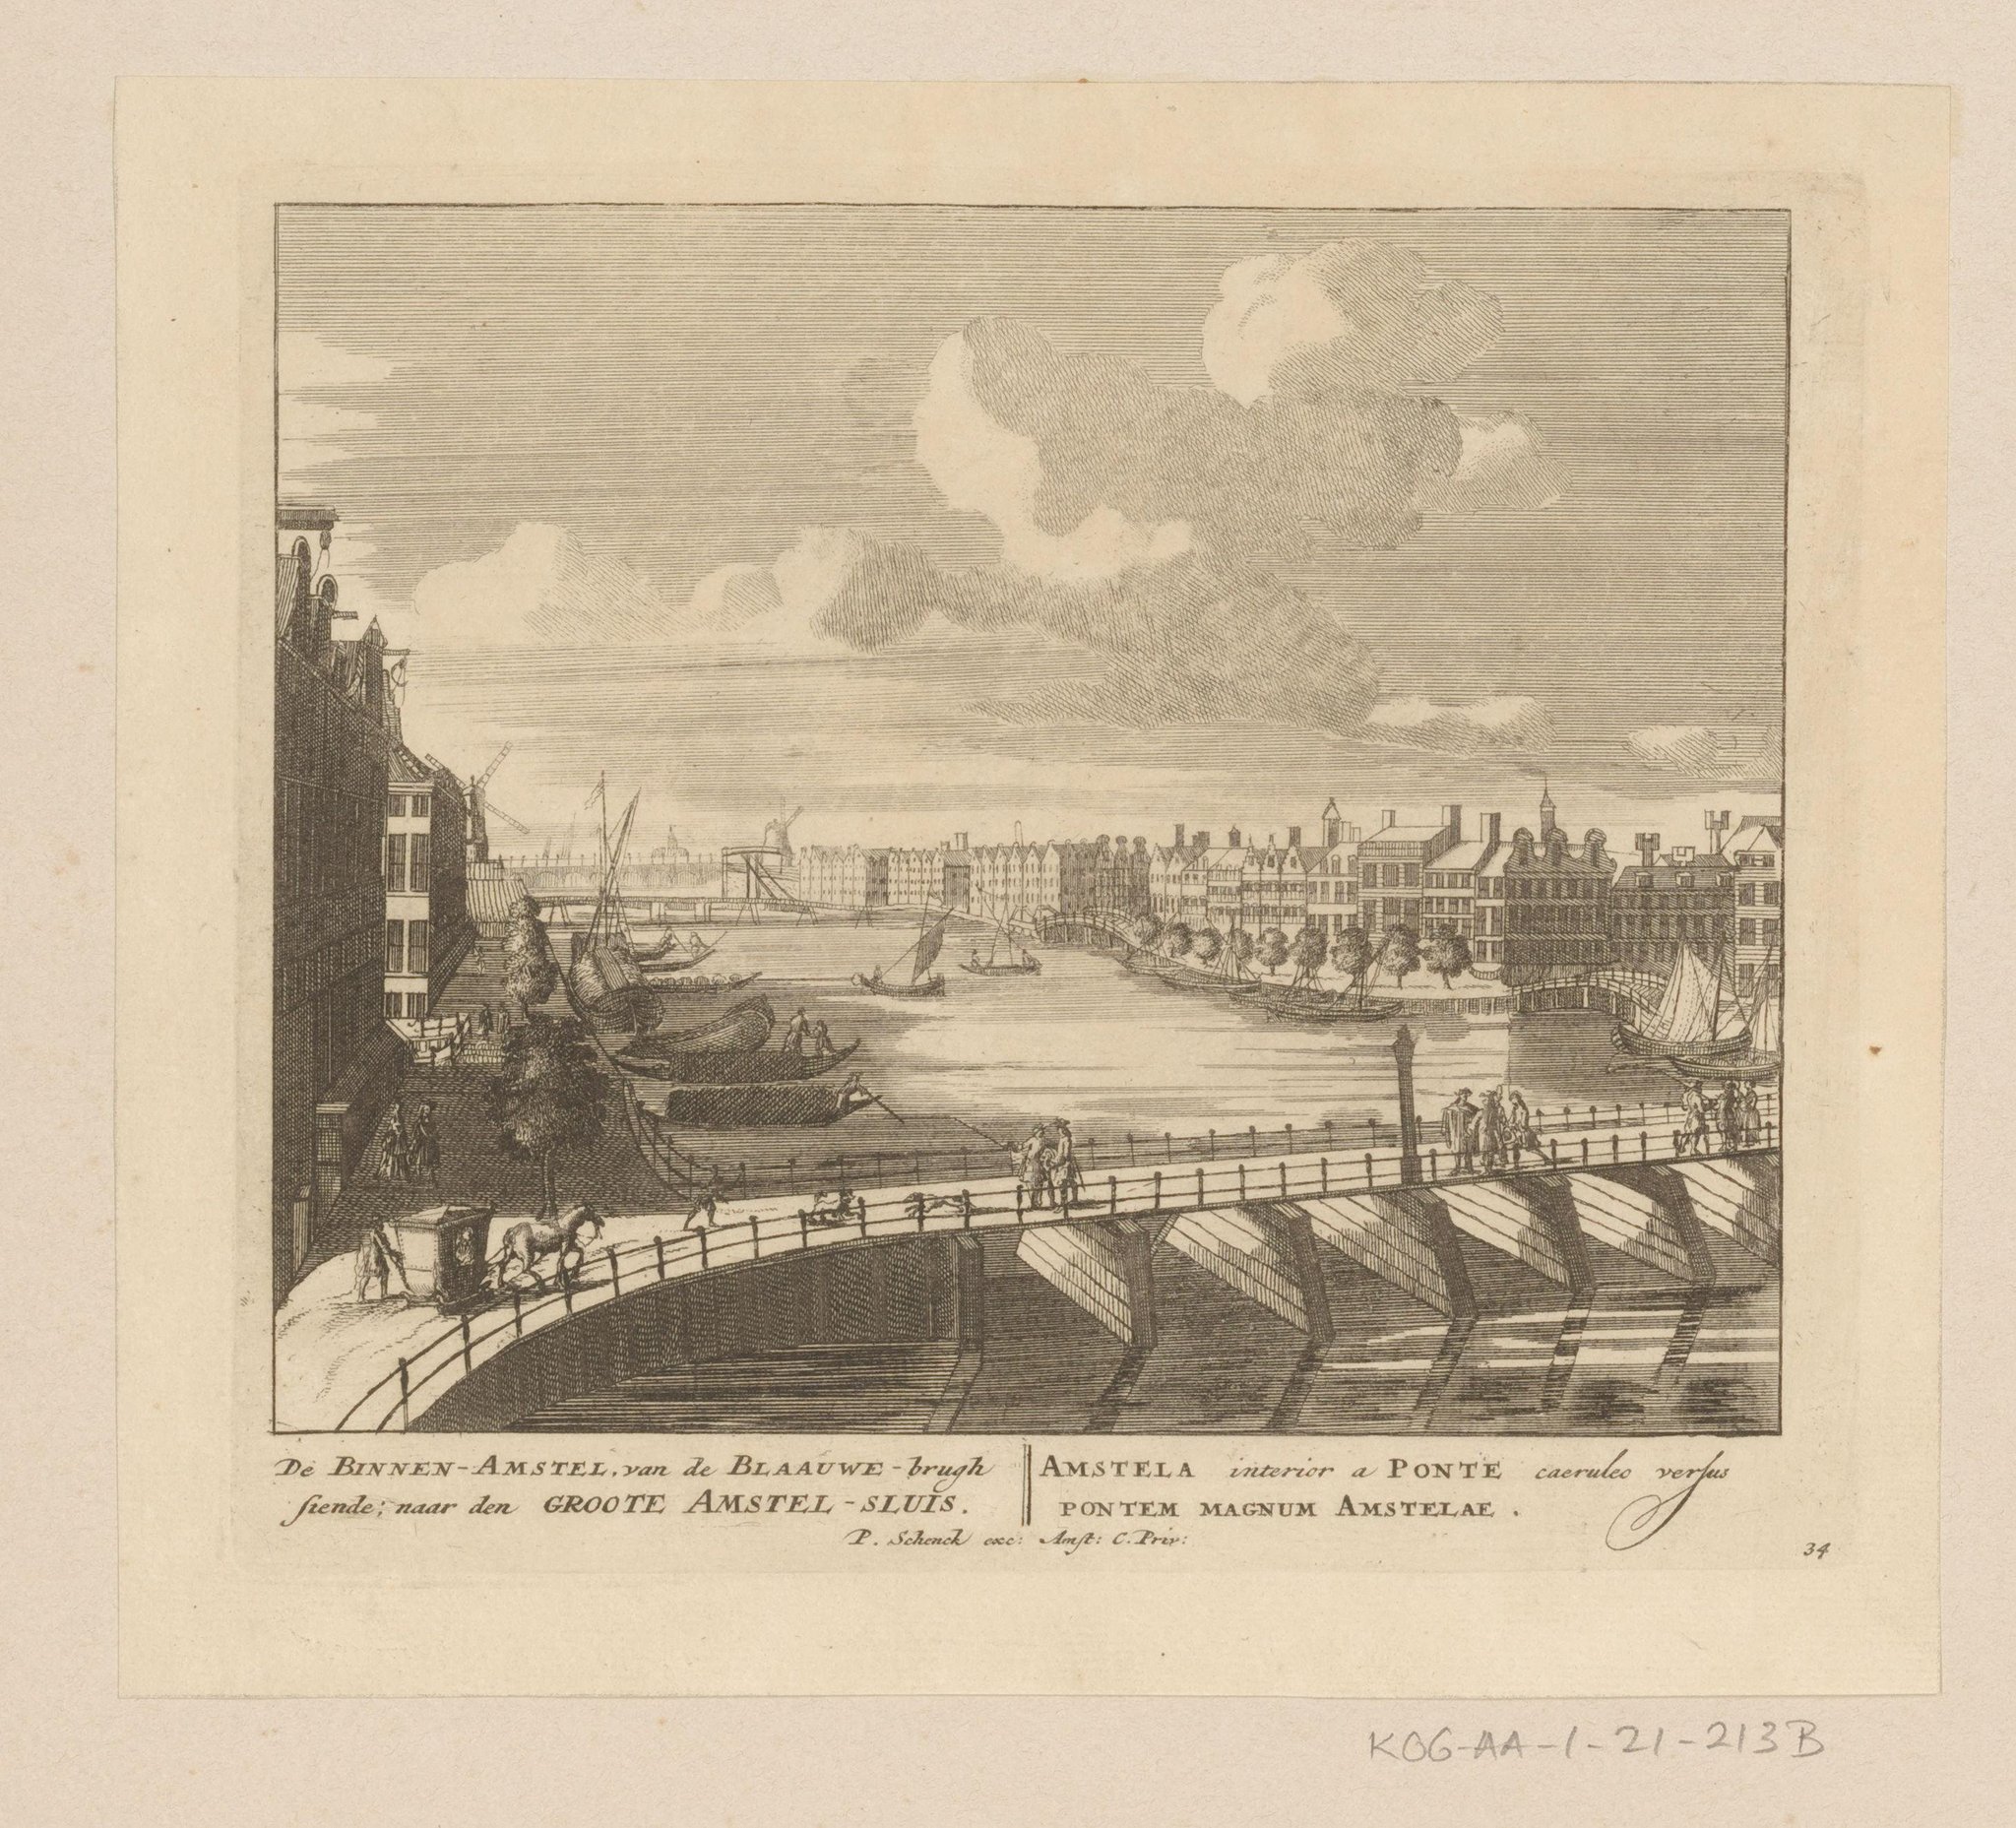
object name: print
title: 100 Afbeeldinge der voornaamste gebouwen van Amsterdam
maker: Anonymous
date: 1710-1711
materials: paper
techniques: etching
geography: amsterdam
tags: city-view, and landscape with man-made constructions, canals, waters (in city), bridge in city across river, canal, etc., boat propelled by man or animal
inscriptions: collector's mark: Lugt 1641b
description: Prent mogelijk uit: 100 Afbeeldinge der voornaamste gebouwen van Amsterdam. Amsterdam: Pieter Schenk (I), s.a. [1710-1711]. Of uit: 100 Afbeeldinge der voornaamste gebouwen van Amsterdam. Amsterdam: Barent Greve, s.a. [1757-1766]. In de tweede uitgave, uitgegeven door Barent Greve, is alleen de titelprent aangepast. De overige prenten zijn onveranderd gebleven.